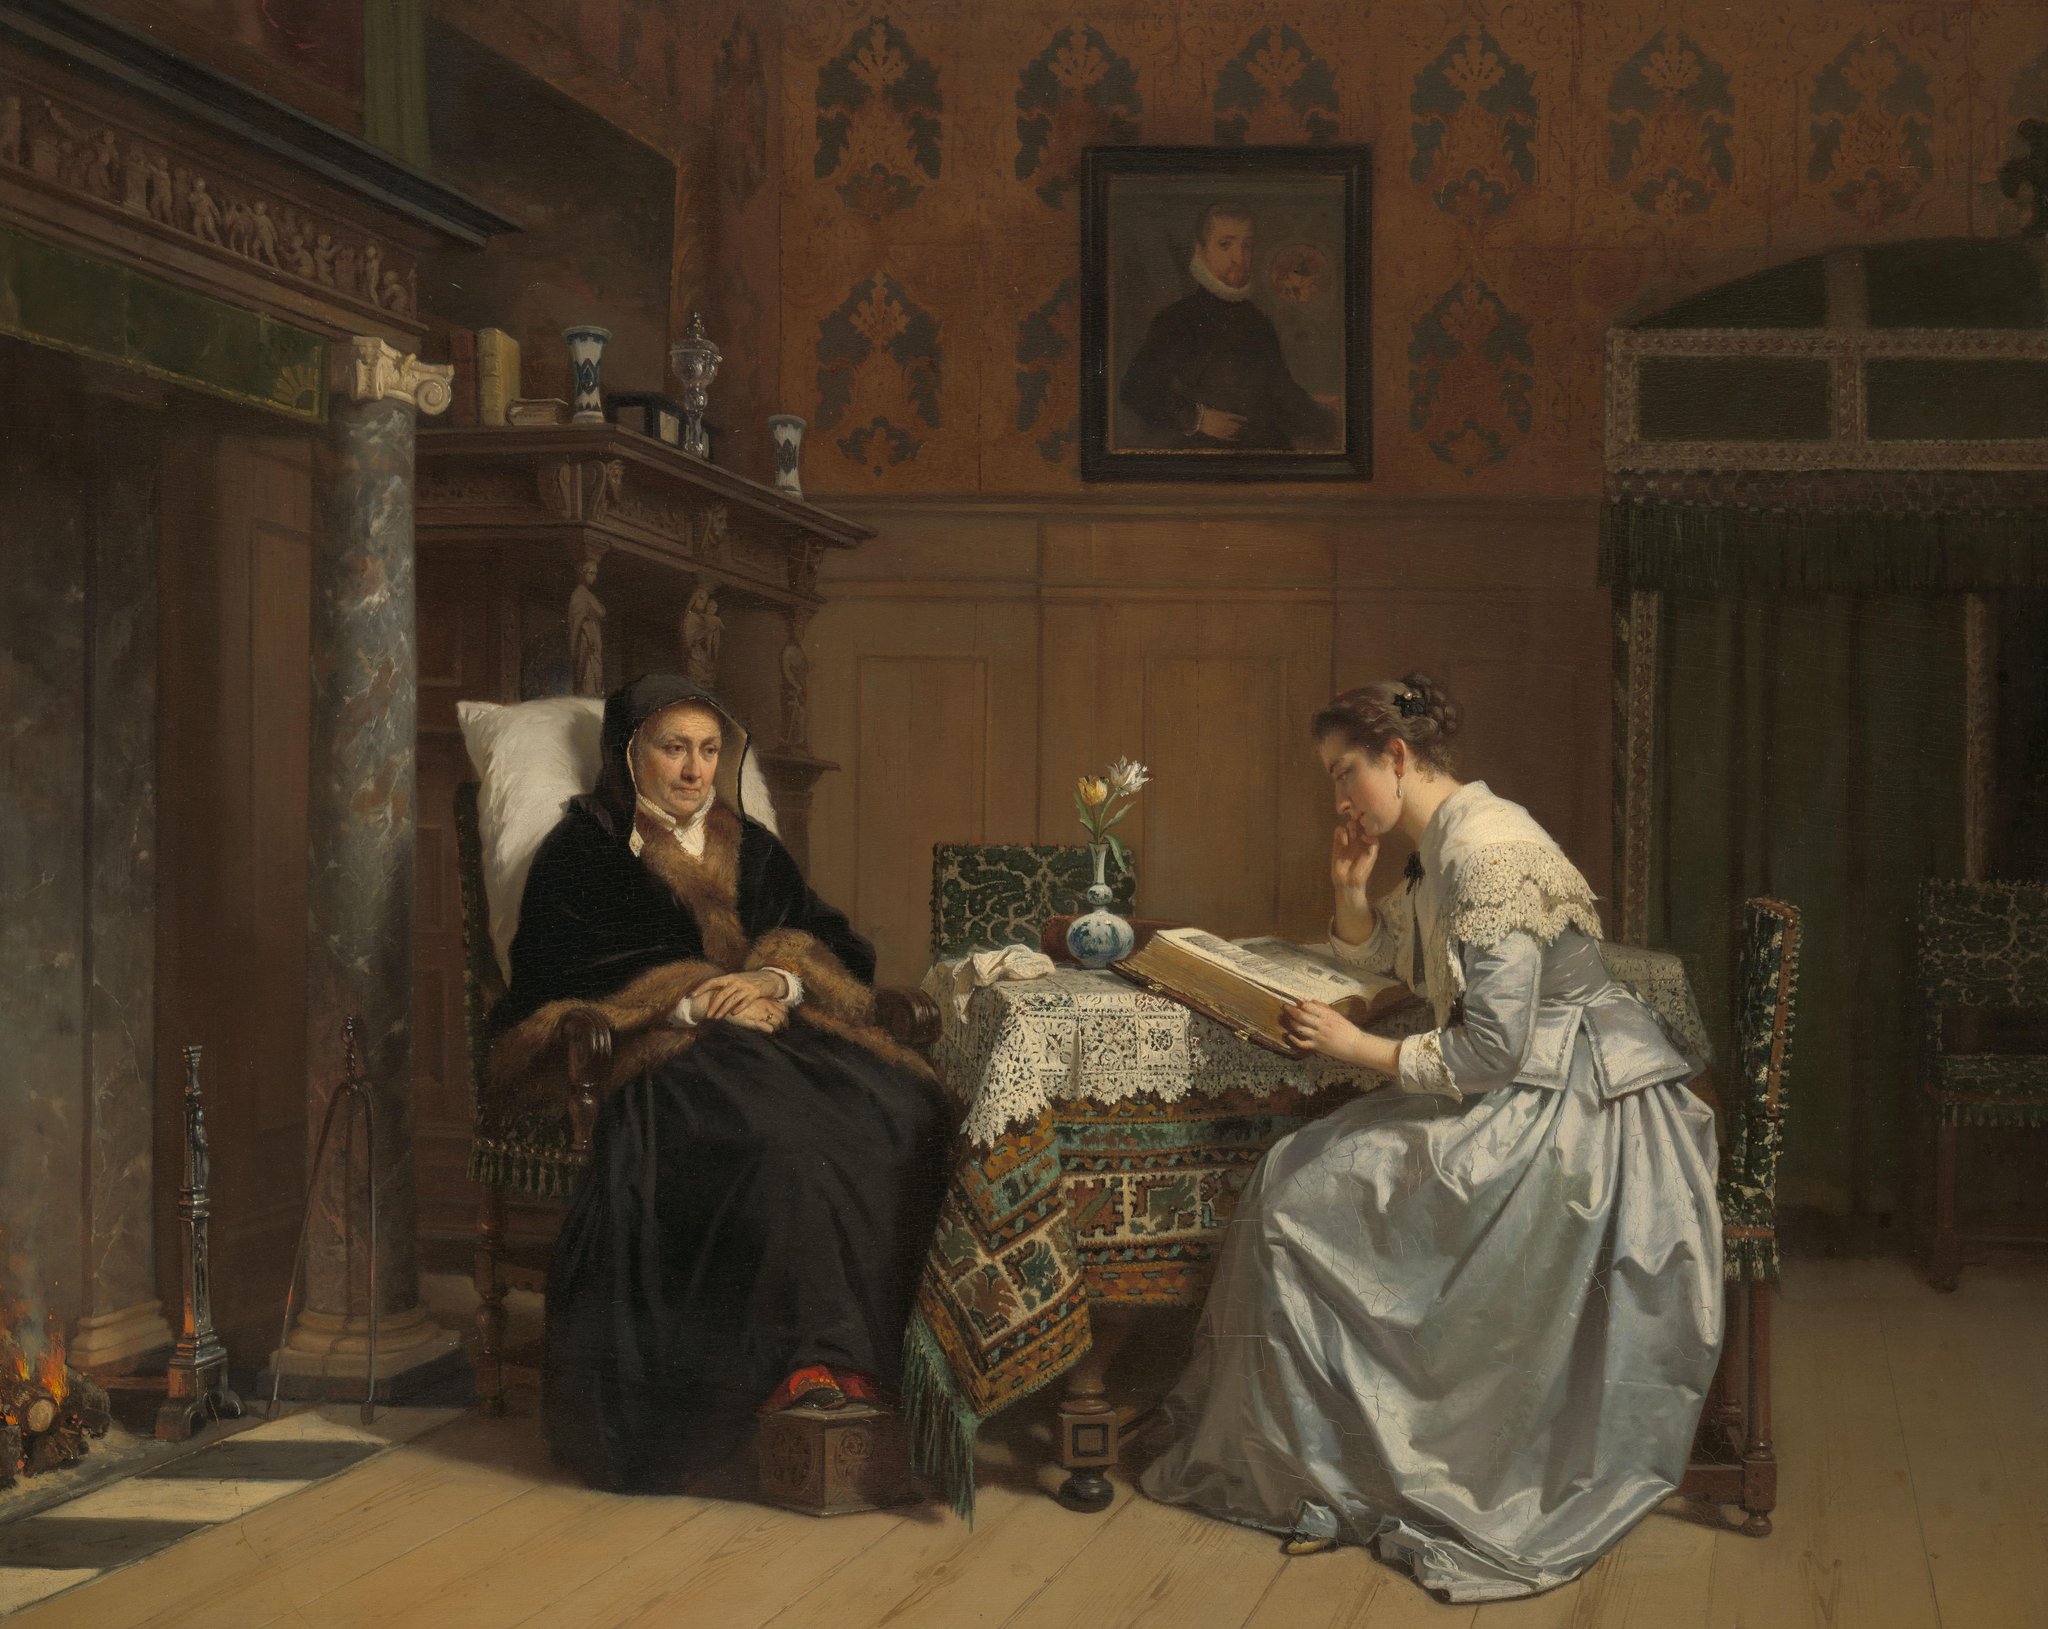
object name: painting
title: Sunday Morning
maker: hendrik jacobus scholten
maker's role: draughtsman, painter, print maker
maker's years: 1824-1907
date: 1865-1868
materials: oil, panel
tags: reading the bible or other religious books, mother and daughter(s) (family group), reading to somebody, living-room, parlour, sitting-room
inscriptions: signature: ‘H.J. Scholten Ft’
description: Zondagmorgen. In een zeventiende-eeuwse interieur leest een jonge vrouw voor uit een bijbel voor een oude vrouw die links voor de haard in een stoel zit. Op de schouw een fries met putti. Aan de muur een schilderij met mansportret.